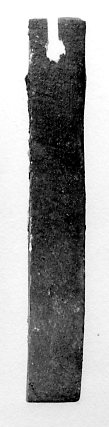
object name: model, bed, strut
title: Strut from a Model Bed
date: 1550-1295 BCE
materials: wood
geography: egypt